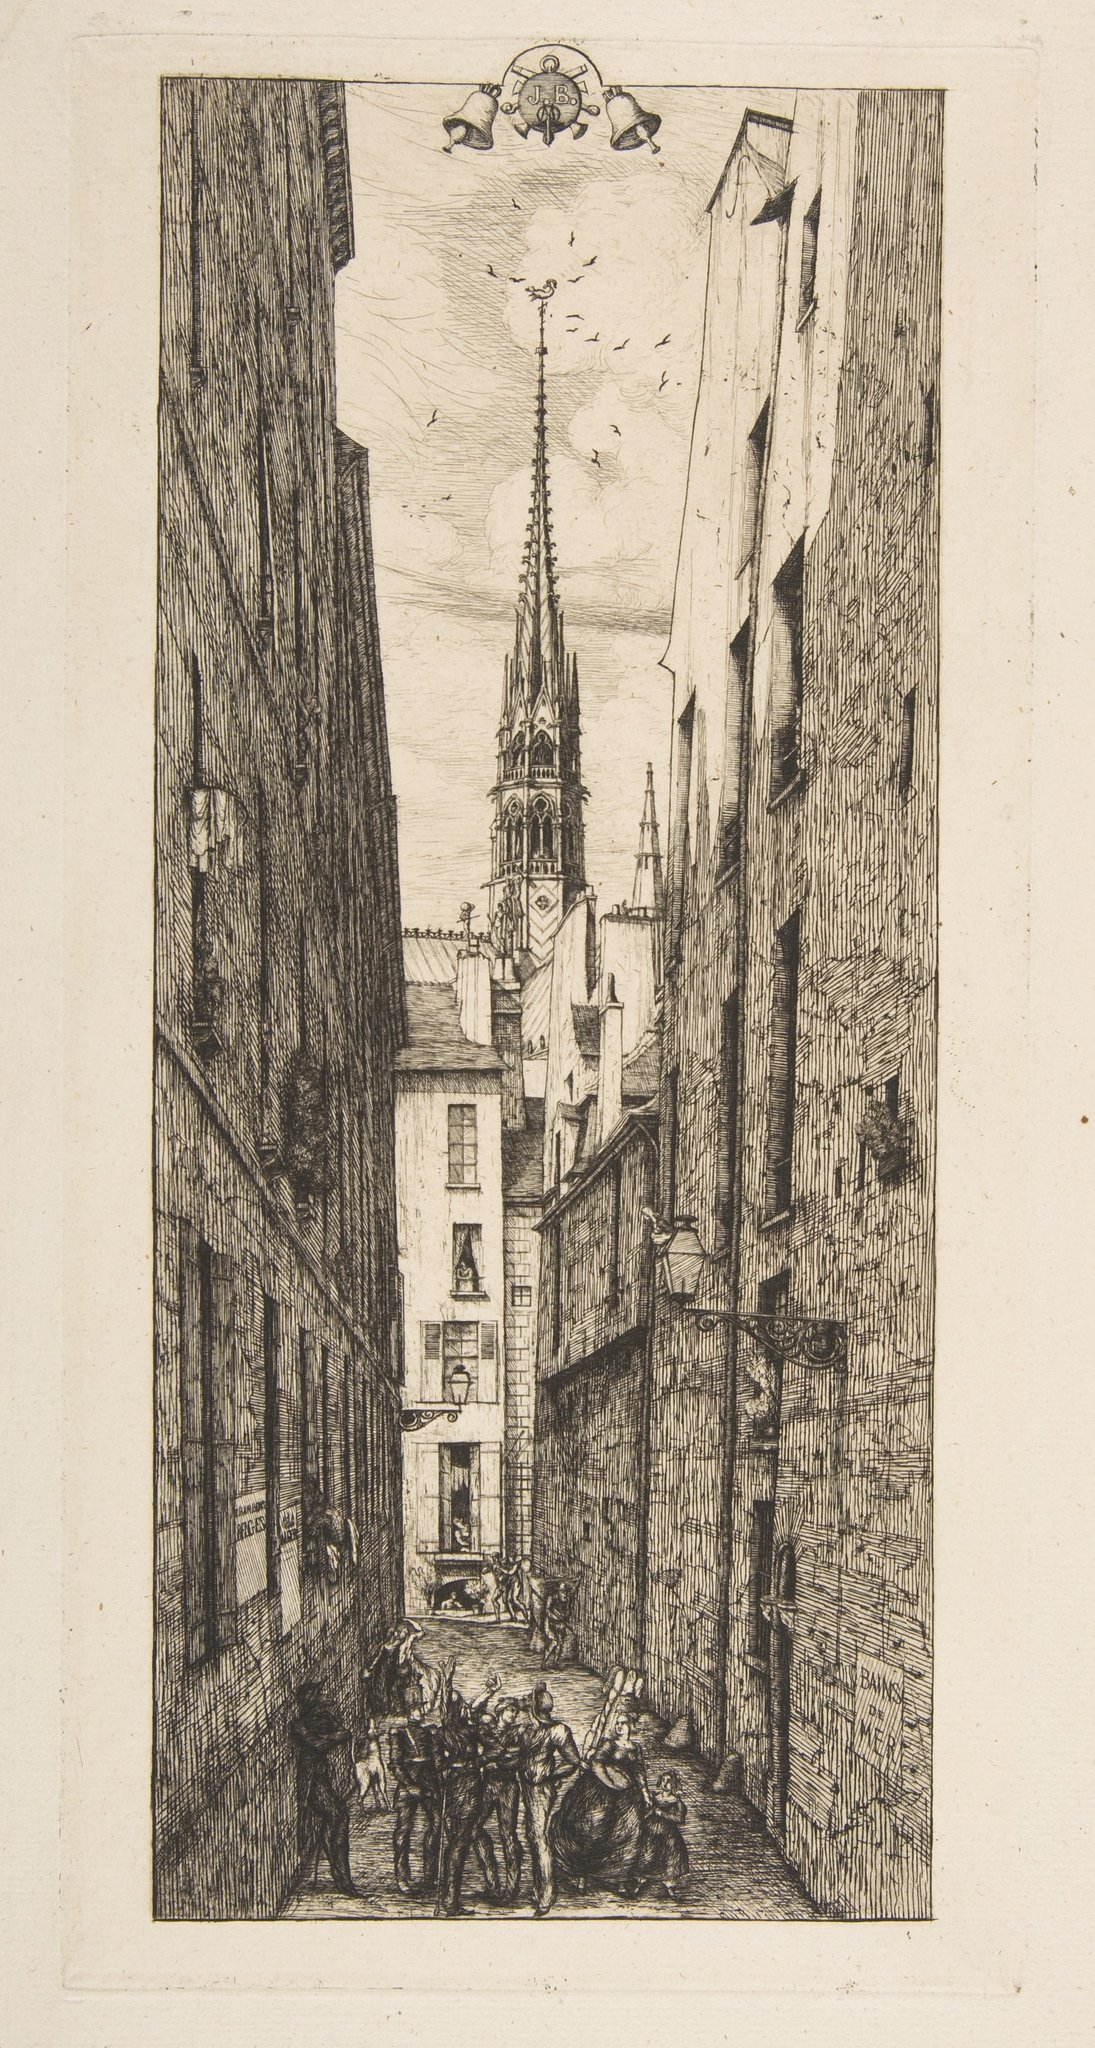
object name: print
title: La Rue des Chantres (Rue des Chantres, Paris)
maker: charles meryon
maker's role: artist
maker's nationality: french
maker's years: 1821-1868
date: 1862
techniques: etching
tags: buildings,paris